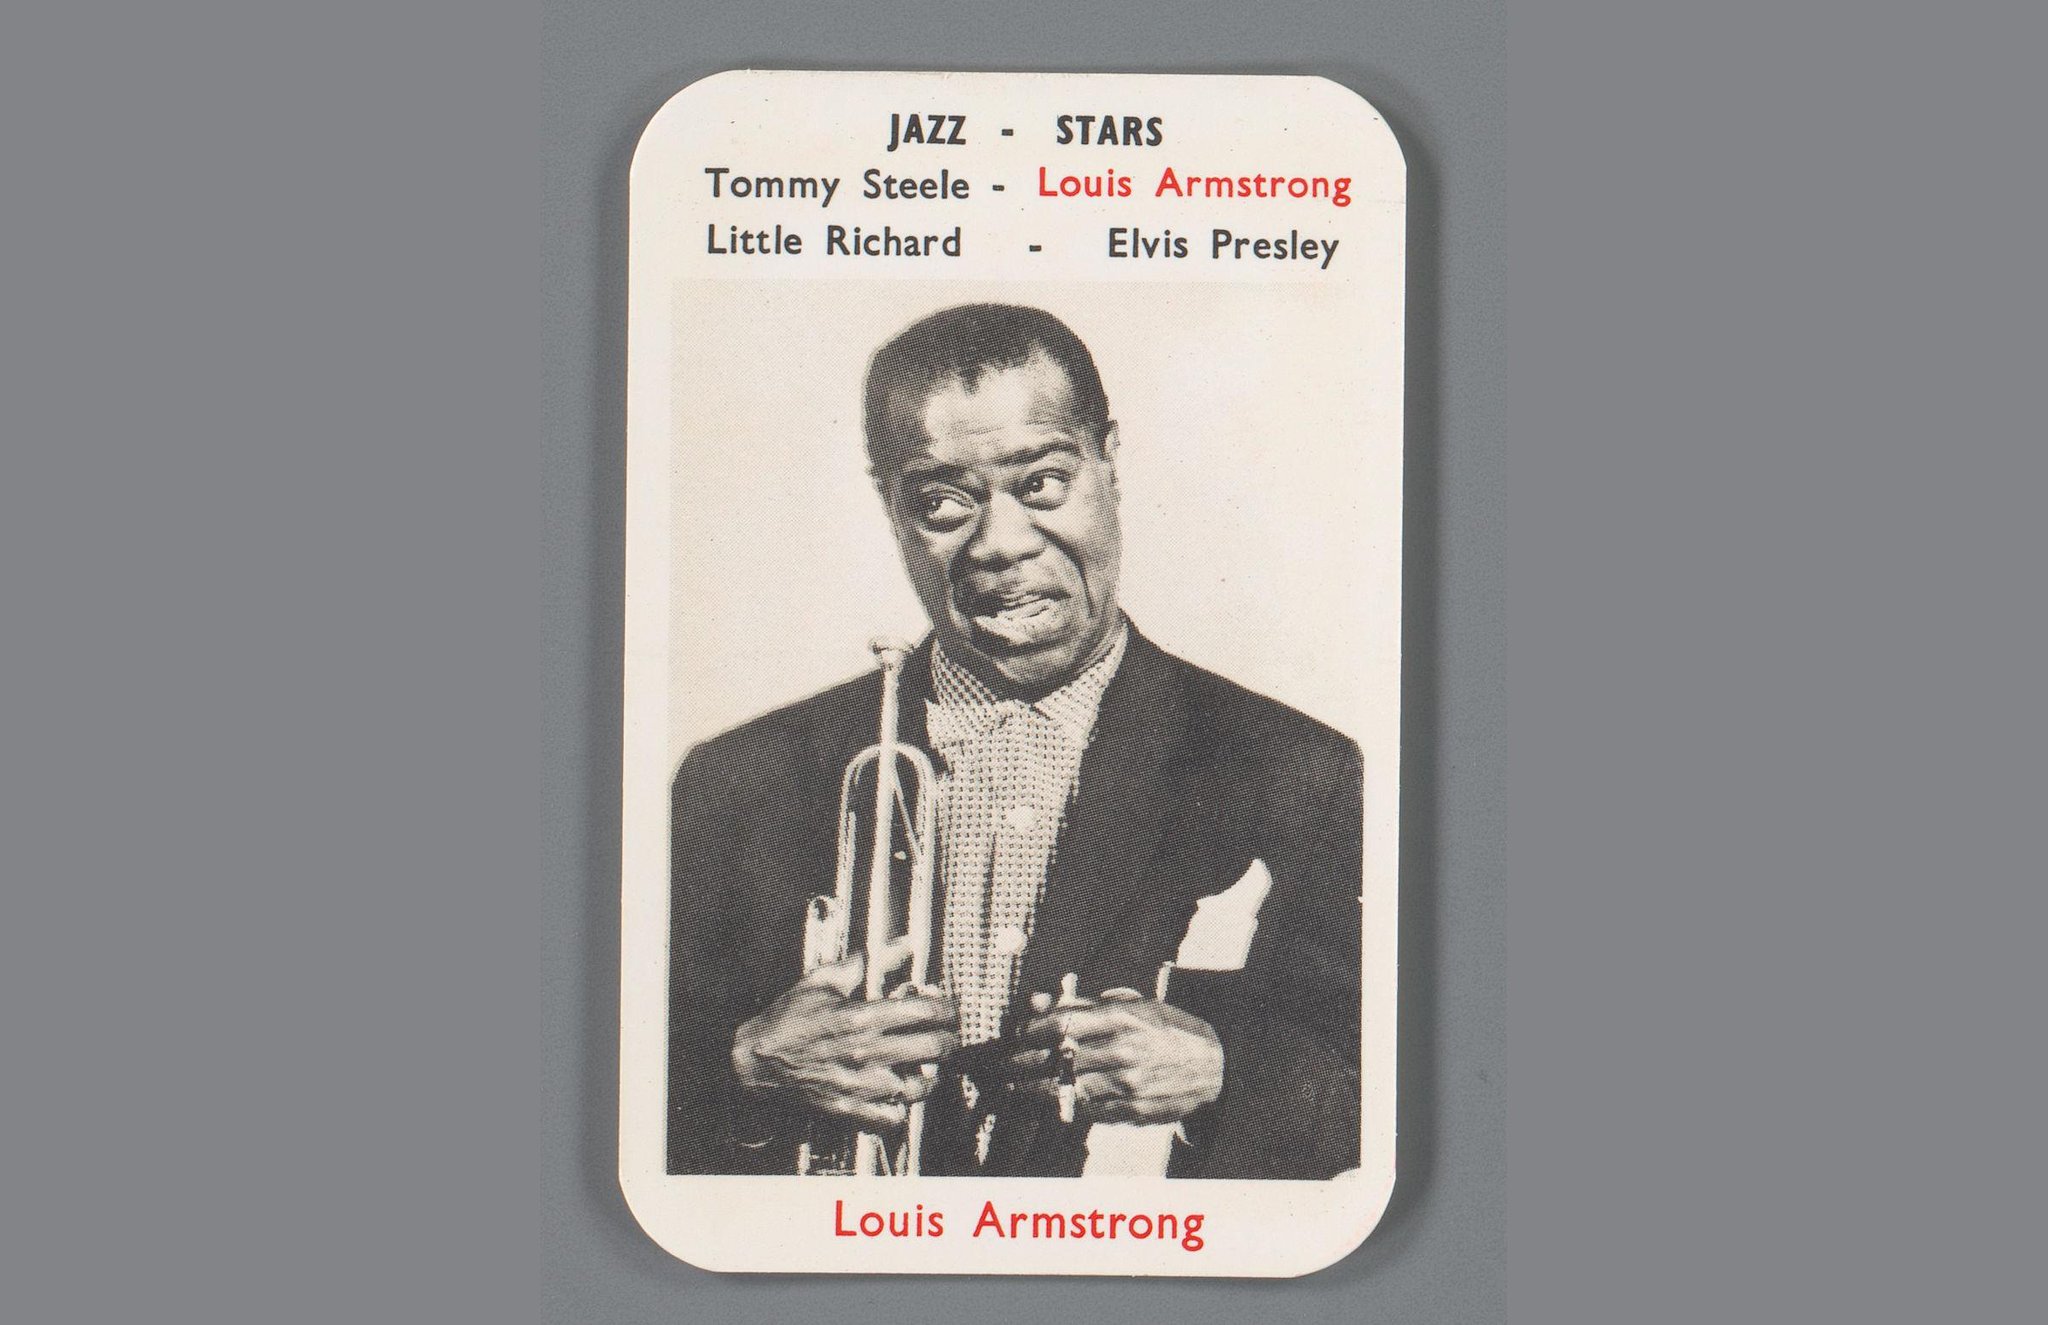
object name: photomechanical print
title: Jazz Stars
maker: Anonymous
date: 1960-1970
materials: paper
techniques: autotype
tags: new york (city), musician, portrait of a musician